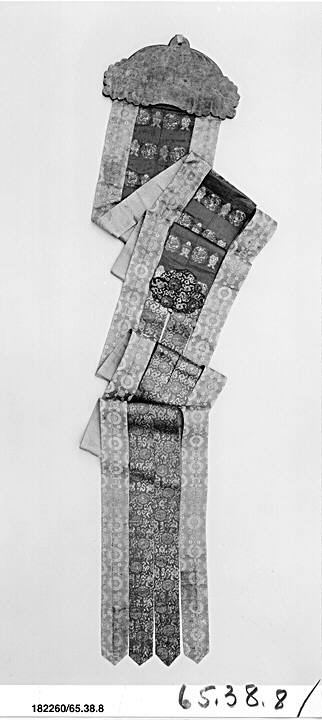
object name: streamer, buddhist temple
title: Buddhist Temple Streamer (one of a pair)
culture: chinese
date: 1736-1795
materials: metal thread, silk, wood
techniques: appliqué, lining